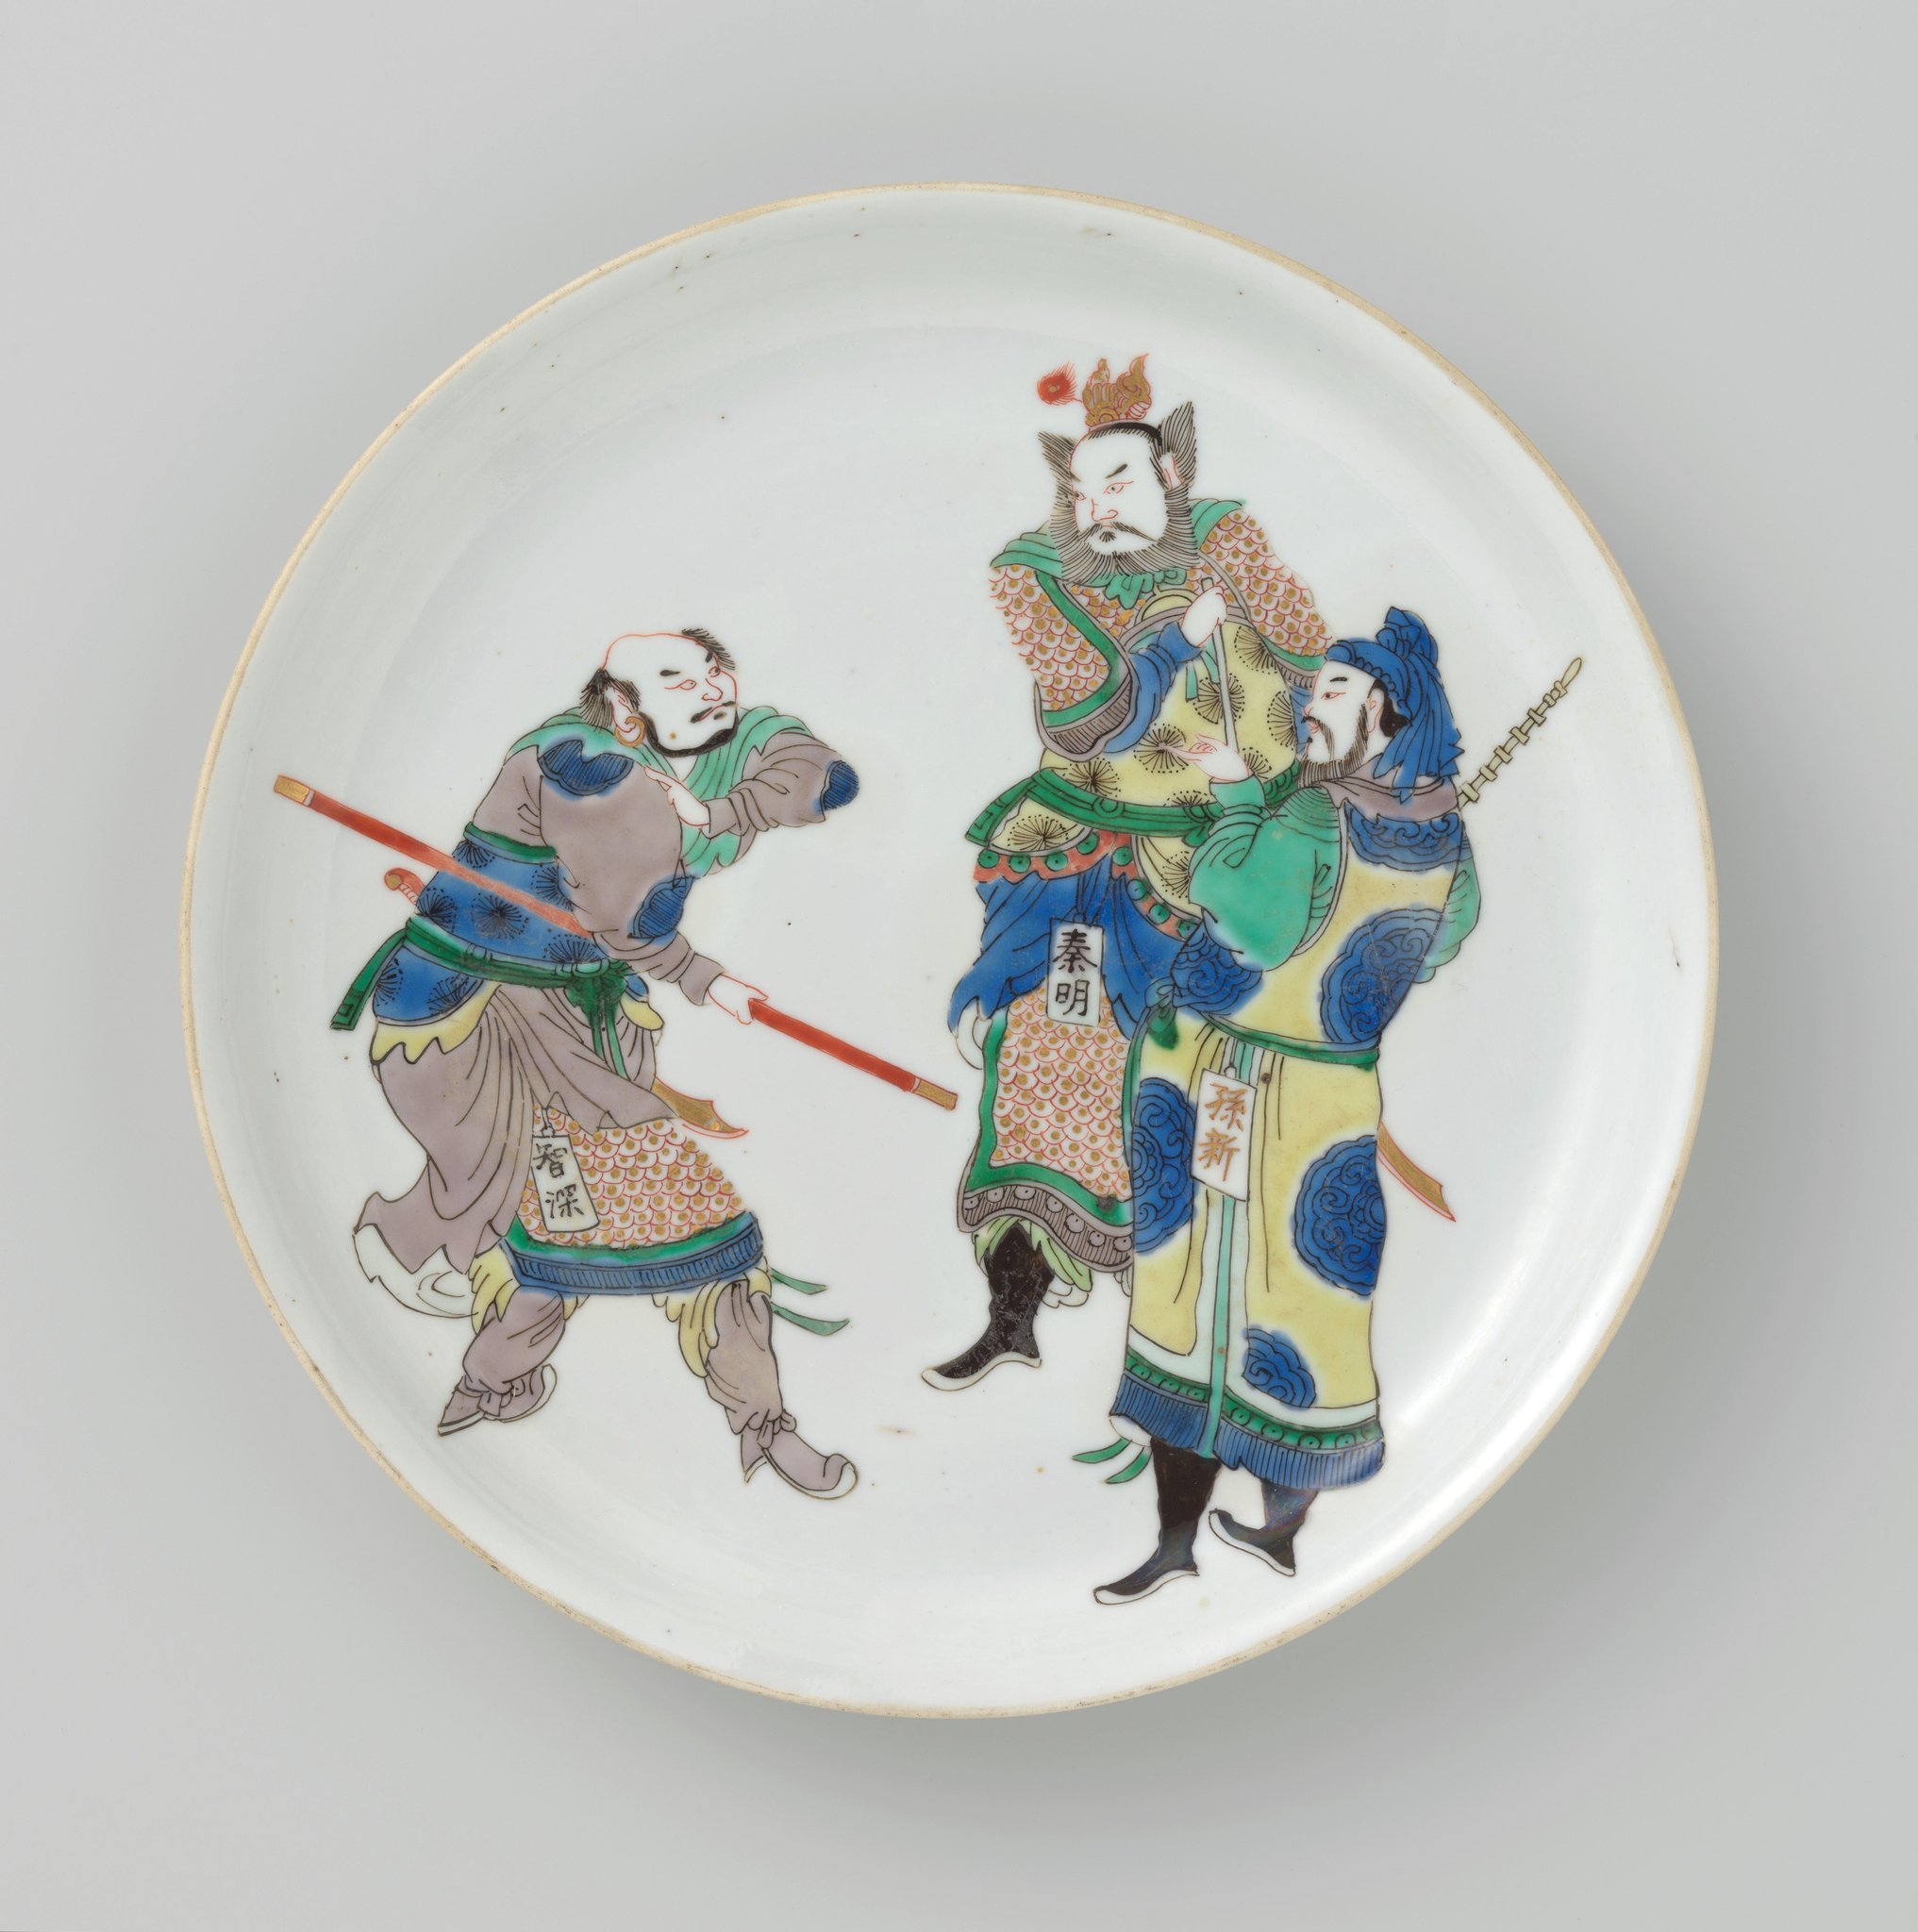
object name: plate dish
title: Bord beschilderd met drie personen uit het boek Water Margin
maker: Anonymous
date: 1690-1710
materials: glaze, porcelain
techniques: gilding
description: Klein bord van Chinees porselein beschilderd in famille verte kleuren. Op de voorzijde drie krijgers uit het boek The Water Margin: (Lu) Zhishen, Qin Ming en Sun Xin. Zij vullen vrijwel het hele oppervlak dat verder wit is gelaten. Famille verte.